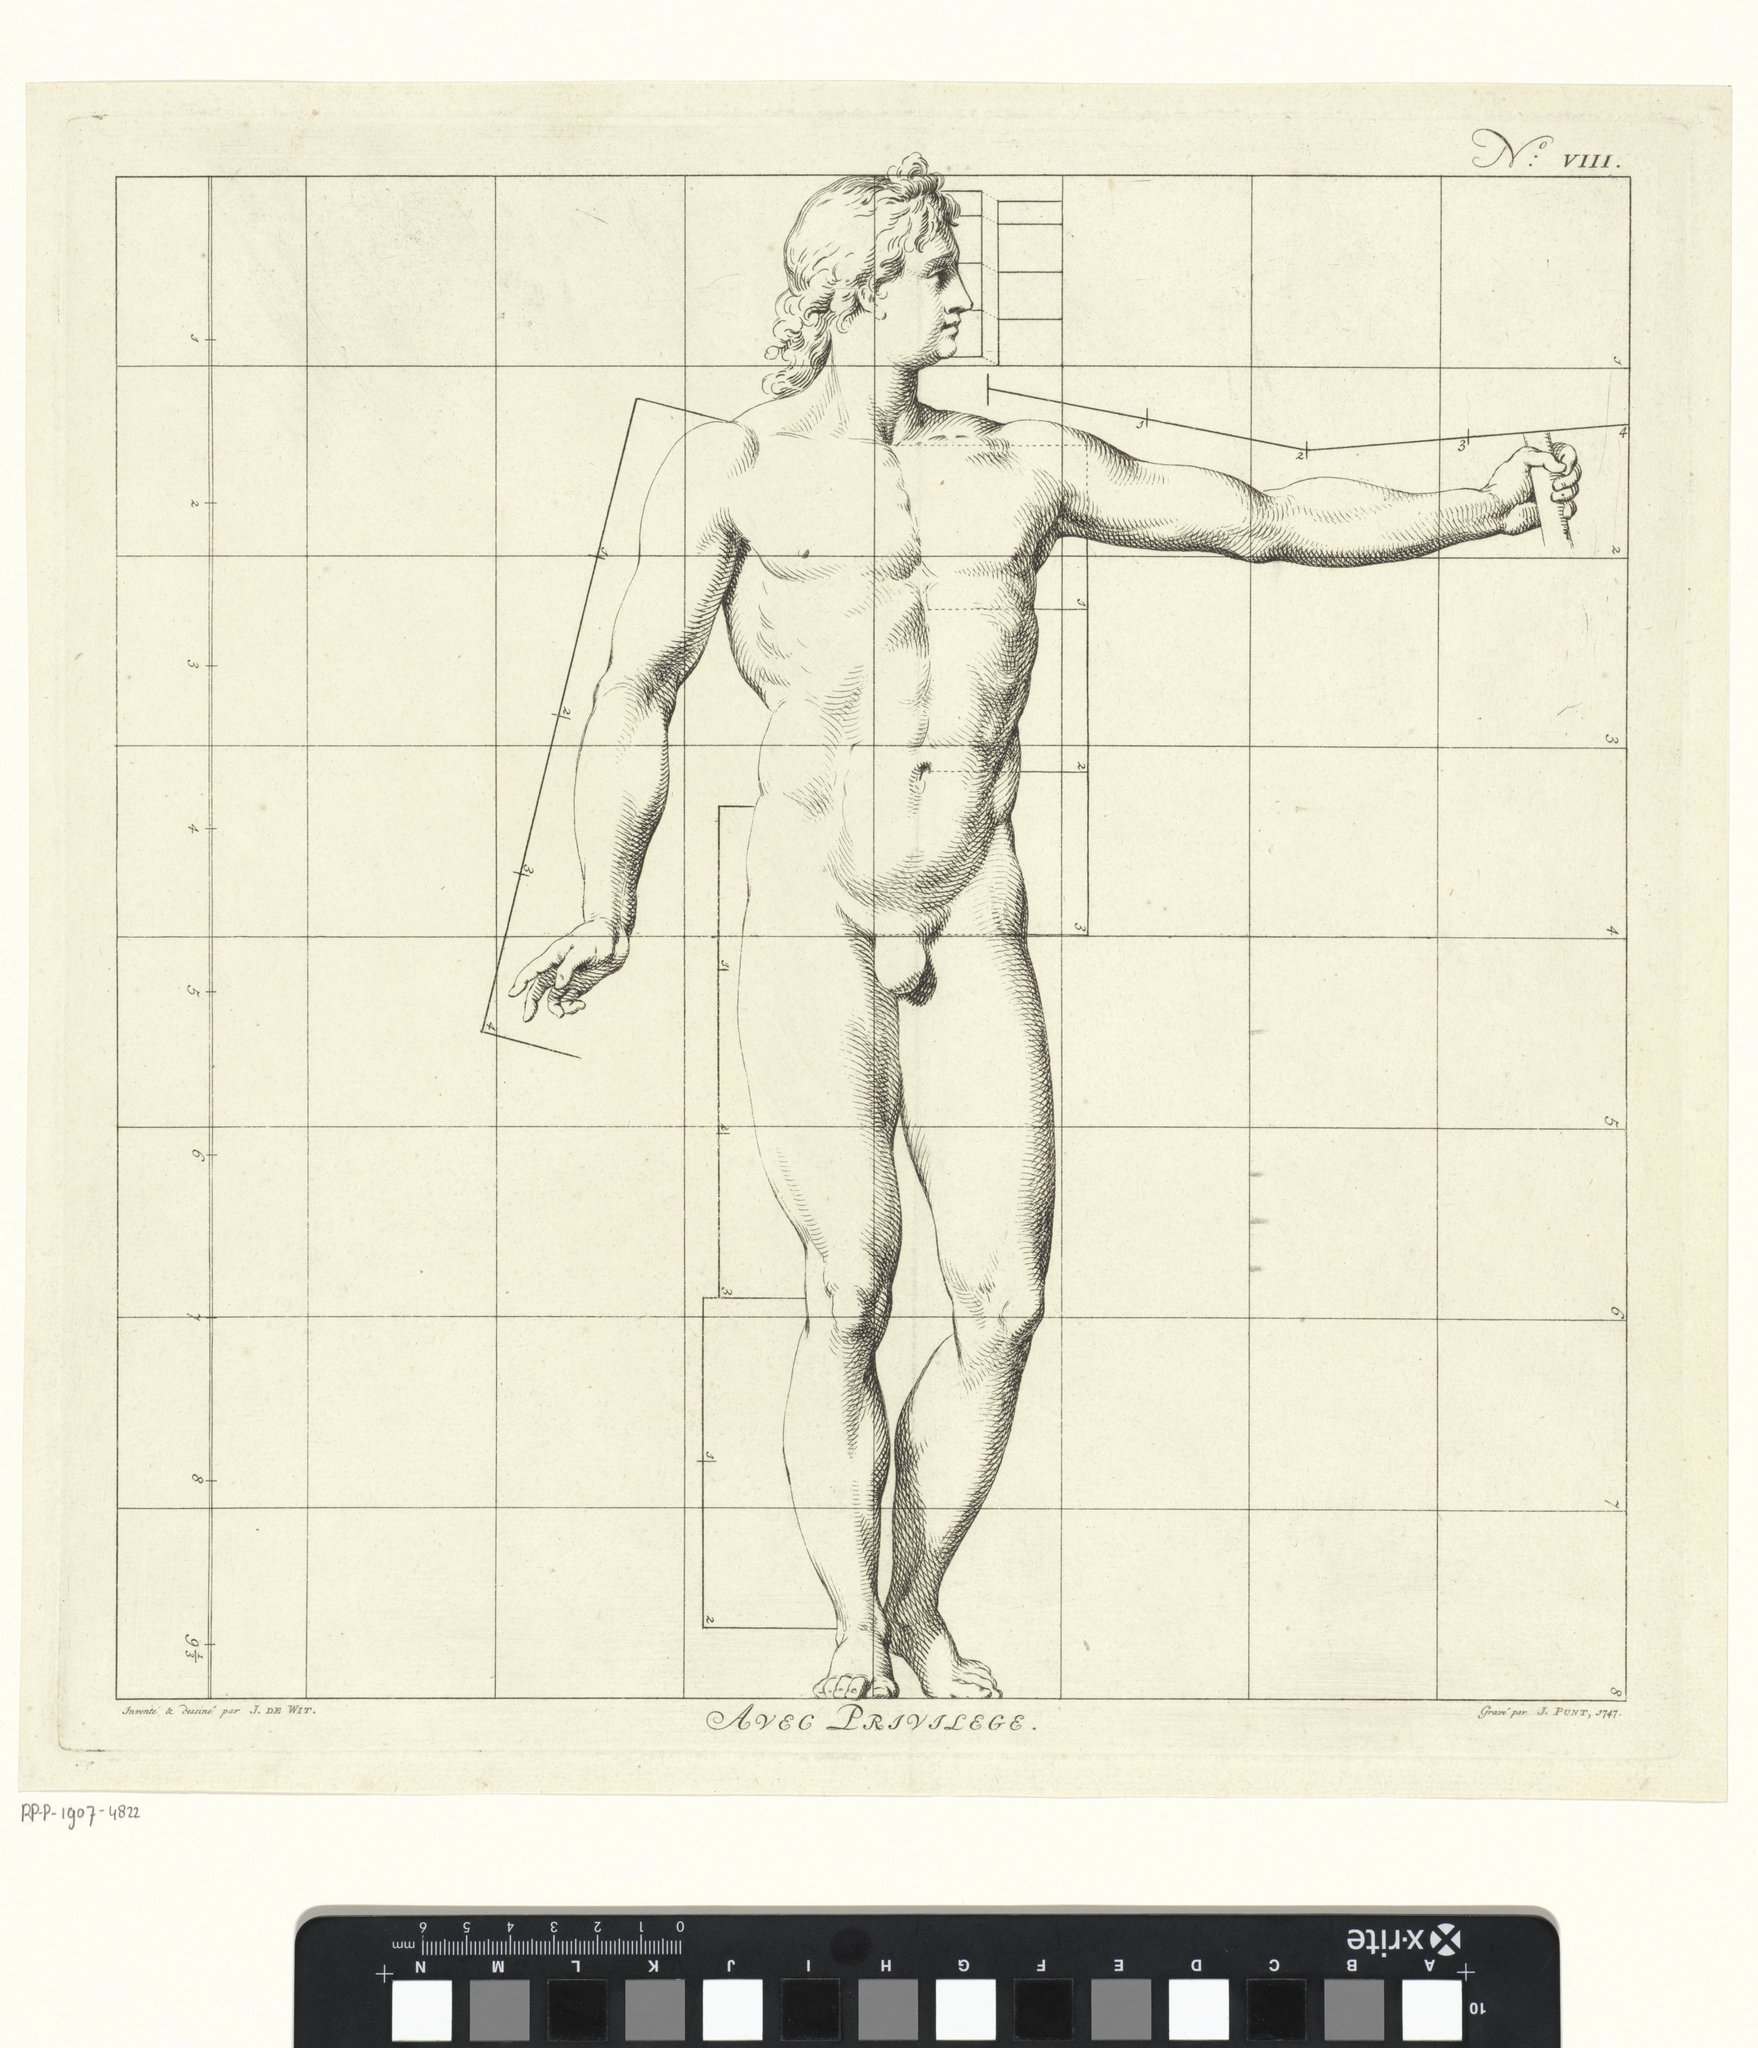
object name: print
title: Teekenboek der Proportien van 't Menschelyke Lighaam / Proportions du Corps Humain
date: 1747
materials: paper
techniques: engraving, etching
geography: amsterdam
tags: (story of) apollo (phoebus), standing figure (canon, proportions) (+ front view), piece of sculpture, reproduction of a piece of sculpture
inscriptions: collector's mark: Lugt 2228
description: Prent uit: Wit, Jacob de. Teekenboek der proportien van 't menschelyke lighaam. = Proportions du corps humain. Amsterdam: Isaak Tirion, 1747.